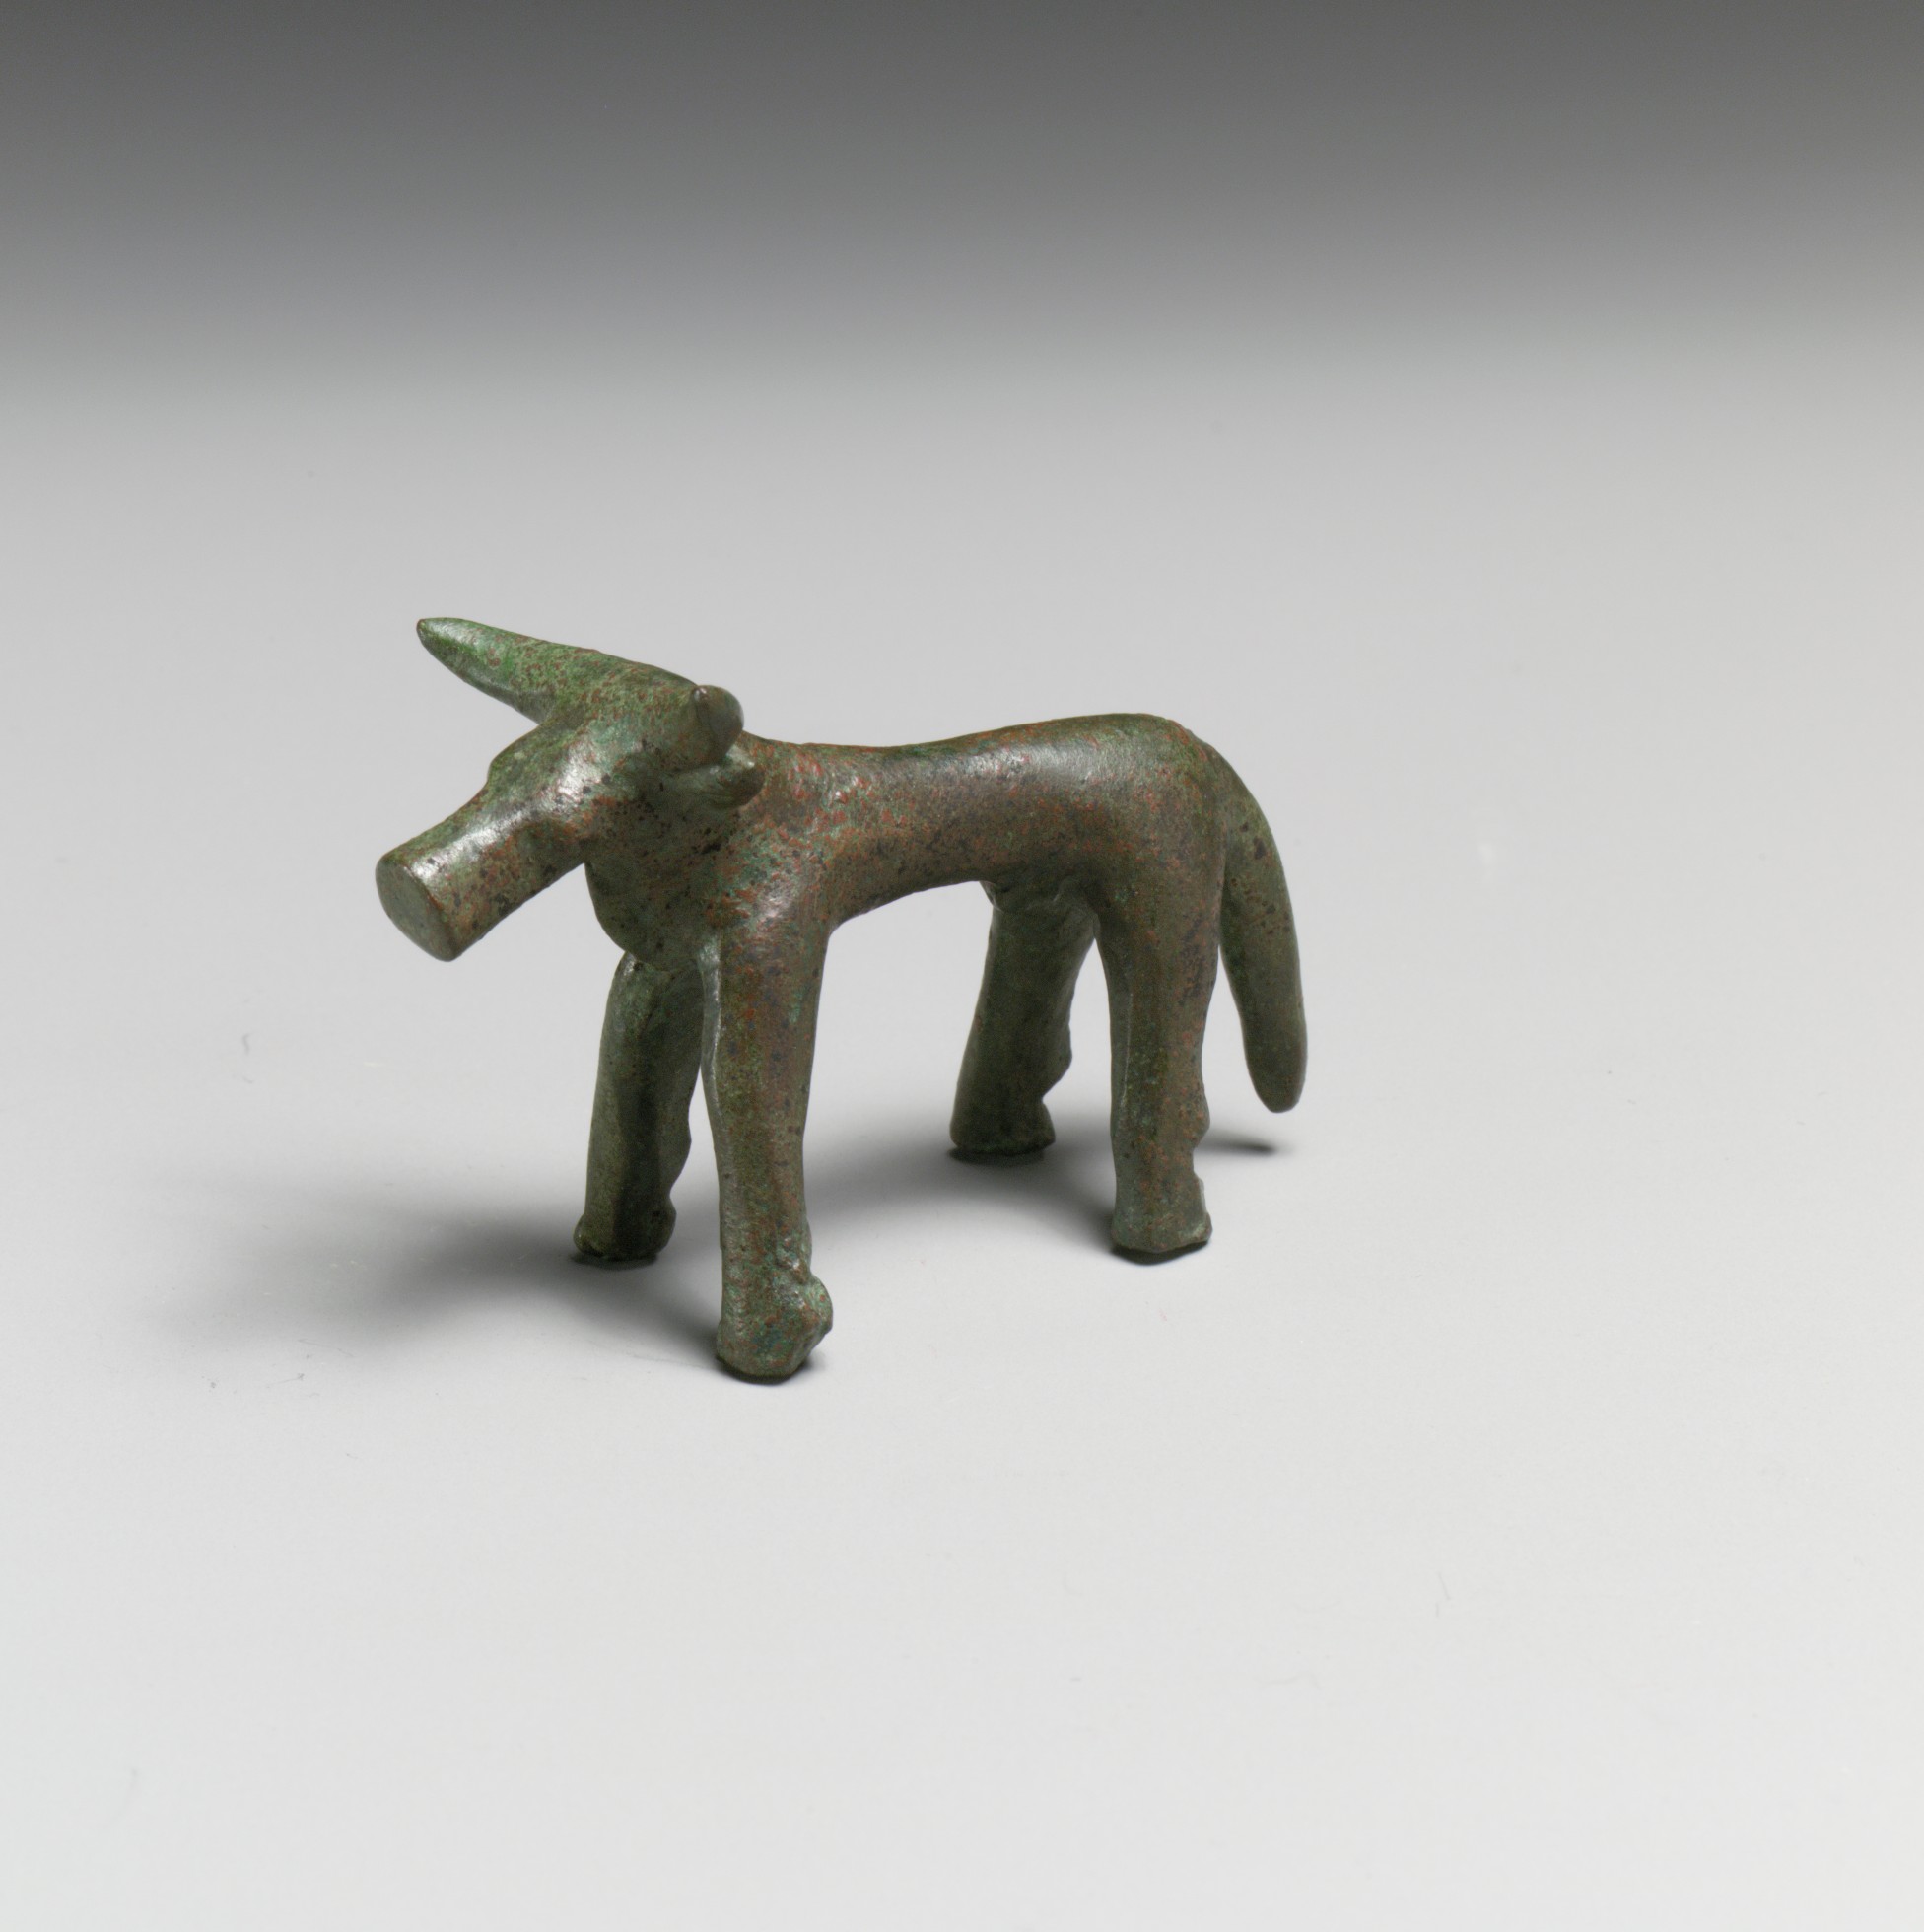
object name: statuette of a bull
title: Bronze statuette of a bull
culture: greek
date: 700-601 BCE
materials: bronze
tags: bulls